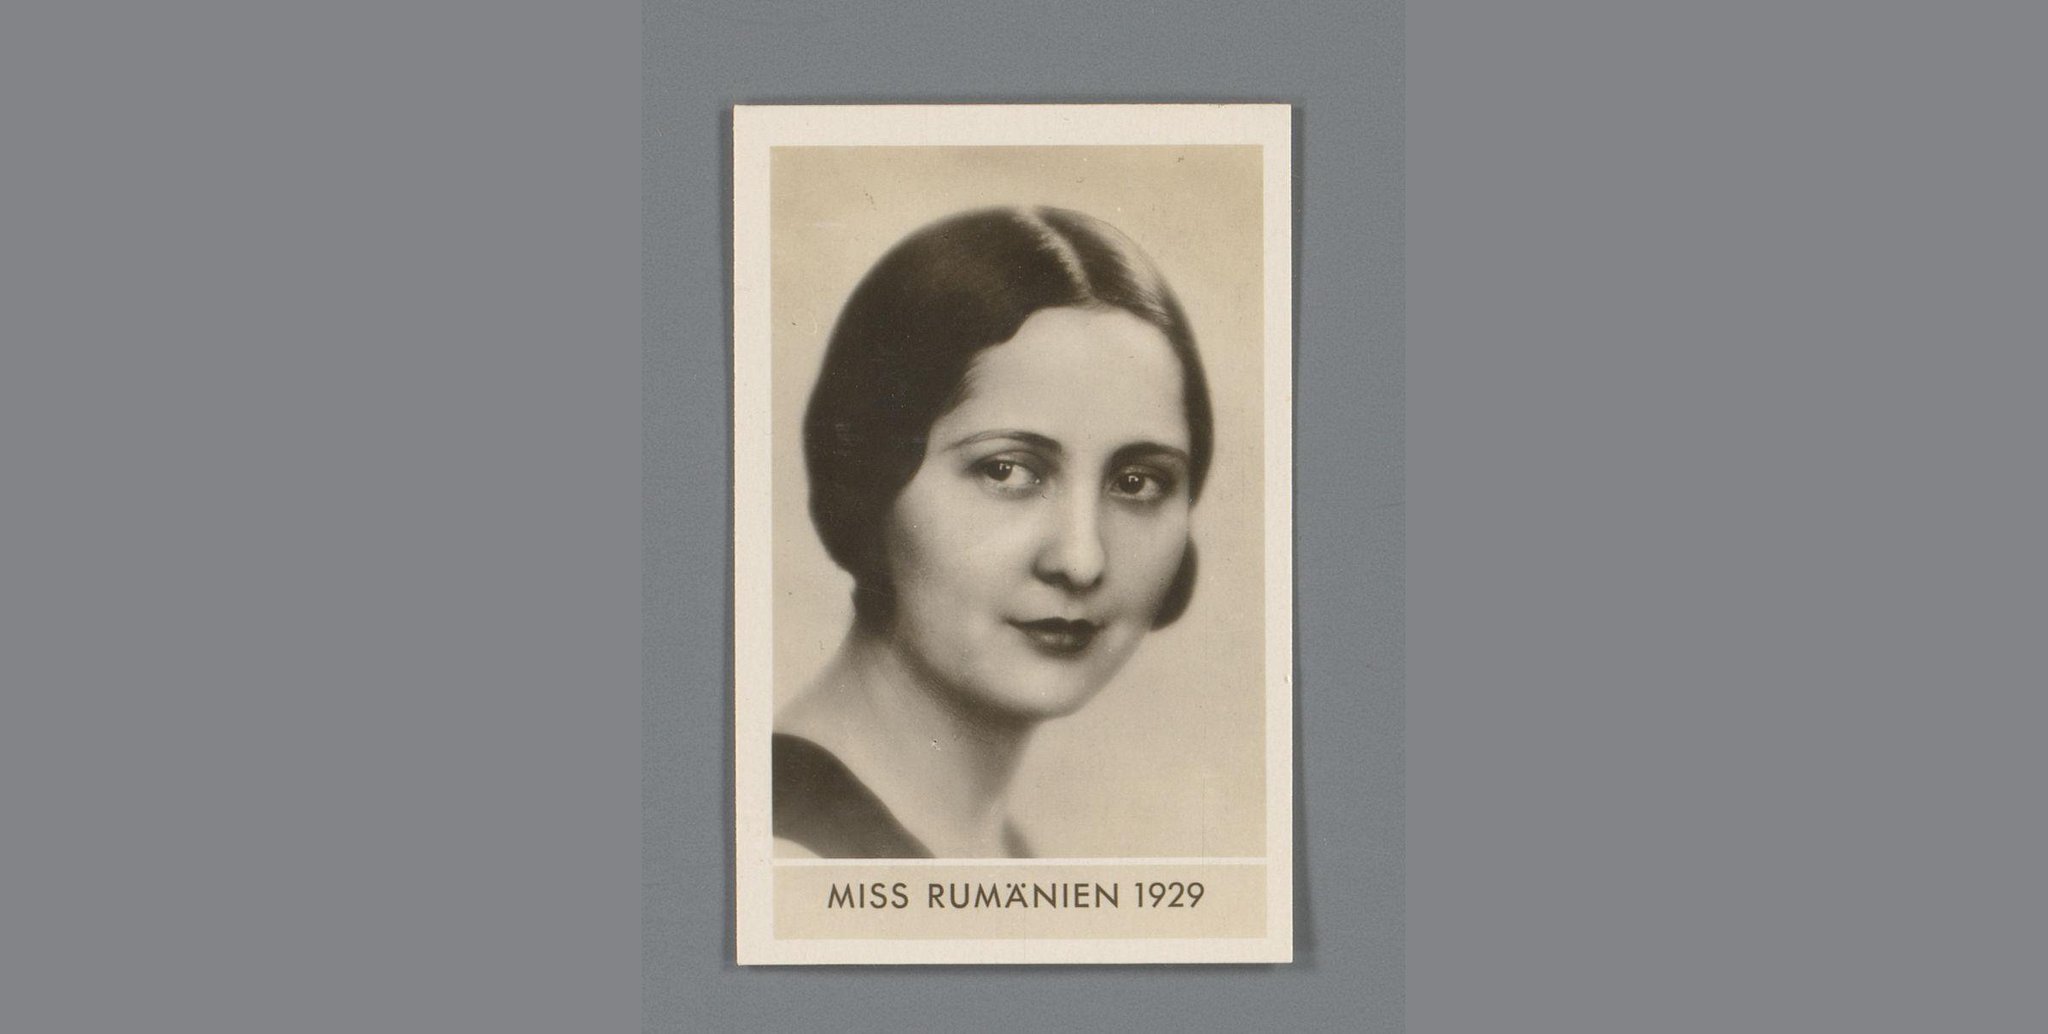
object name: photograph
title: Portret van Marioara Cranescu, Miss Roemenië 1929, reclame voor Club & Liga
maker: Anonymous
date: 1929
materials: paper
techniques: gelatin silver print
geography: dresden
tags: historical persons - bb - woman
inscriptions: inscription: ‘Die schönsten/ Frauen der Welt/ dargestellt durch die Schön-/ heitsköniginnen aller Länder,/ finden Sie in 190 echten/ Bromsilber-Fotos, die nur den/ CLUB-und-LIGA-Packun-/ gen beiliegen. Eind prächtiges/ Sammel-Album erhalten Sie/ für 75 Pfennig vom Händler/ oder bei Einsendung von/ 75 Pfennig in Briefmarken/ von der Bilderstelle Lohse,/ Dresden A24, Nossener Str. 1./ Ges. gesch. Nachdruck verboten!’